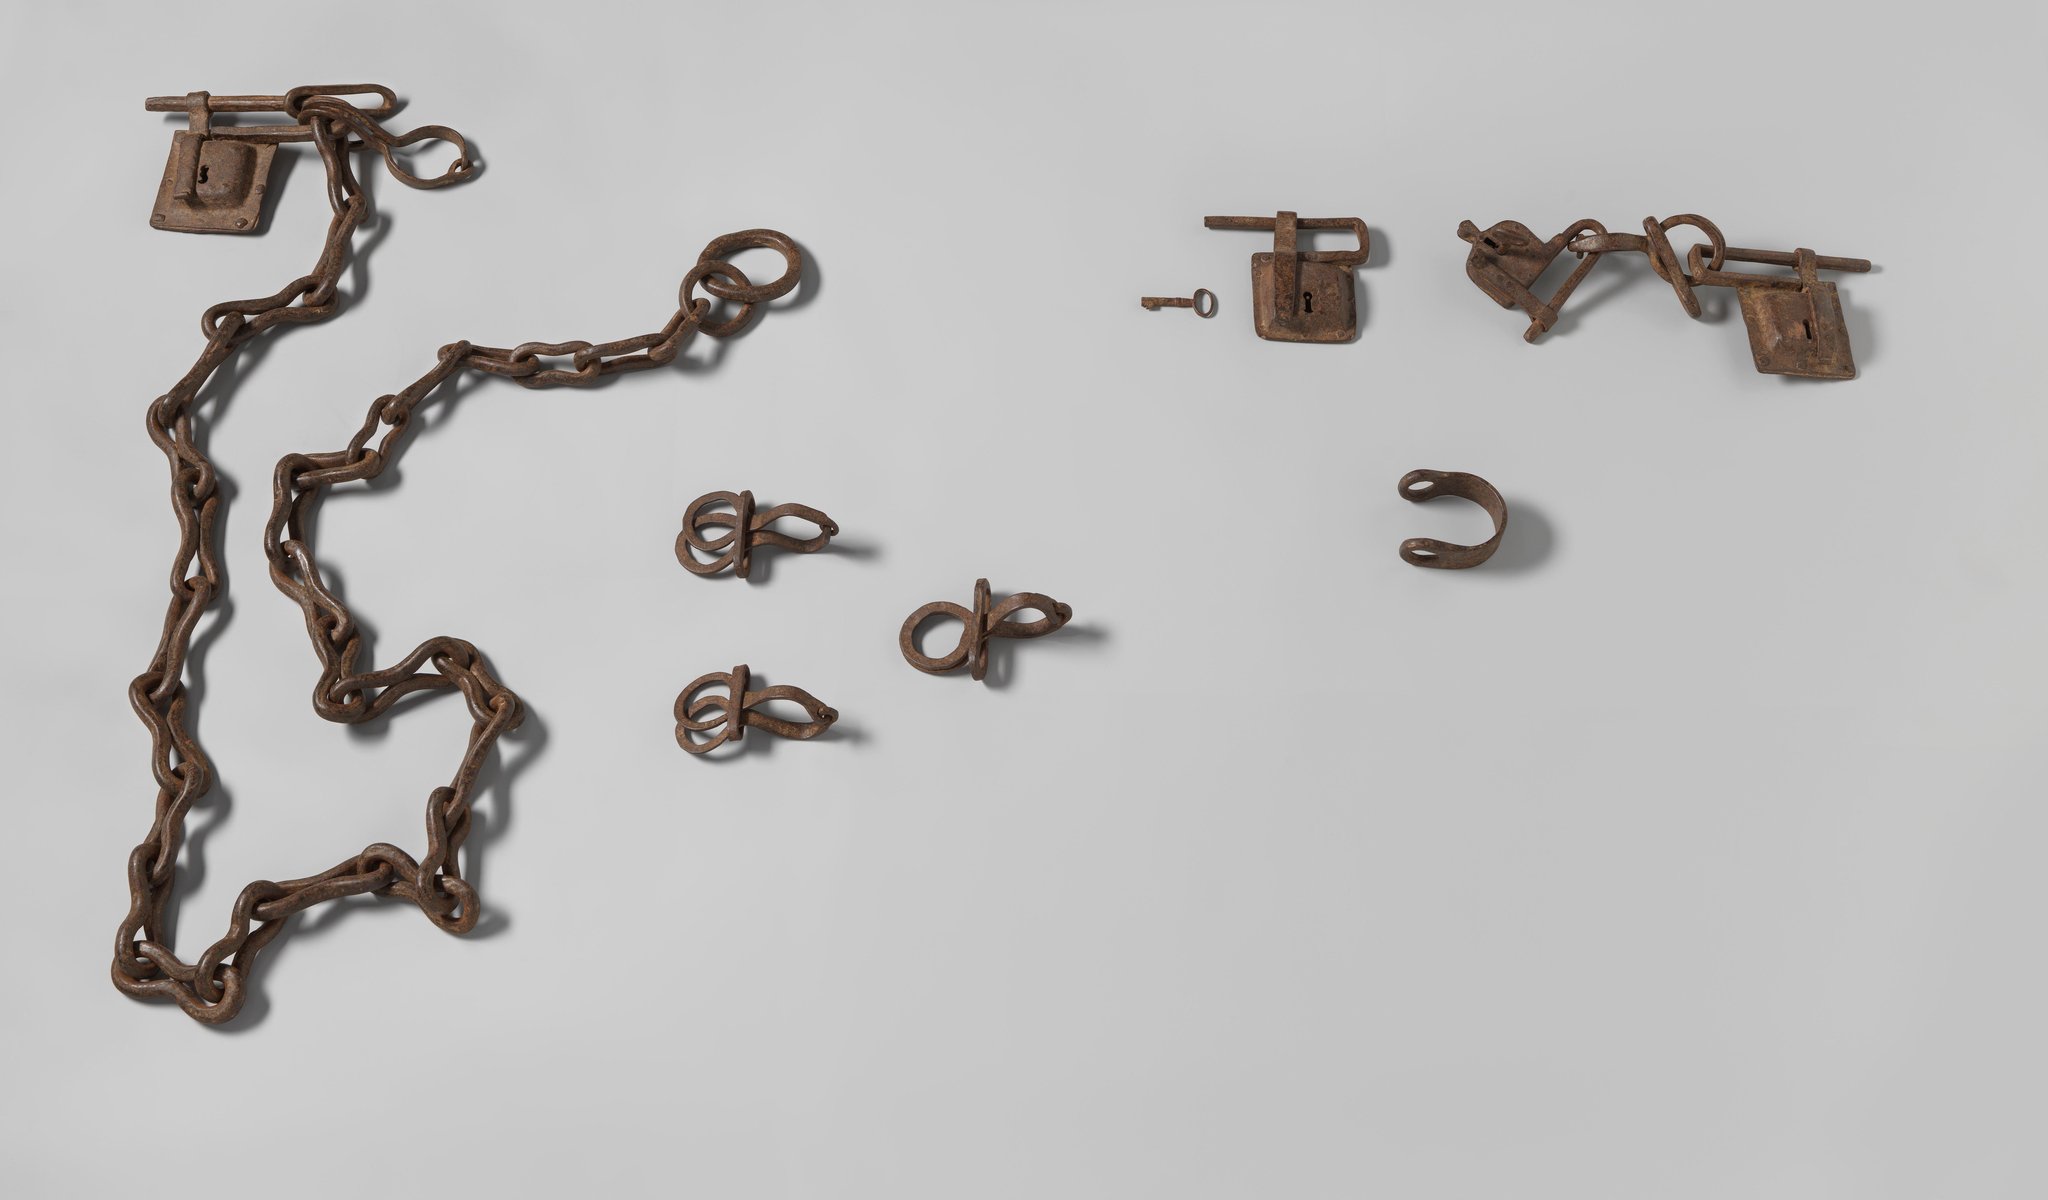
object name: voetboeien, kluister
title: 7 boeien behorende bij een voetblok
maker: Anonymous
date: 1600-1800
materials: iron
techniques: forging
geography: netherlands